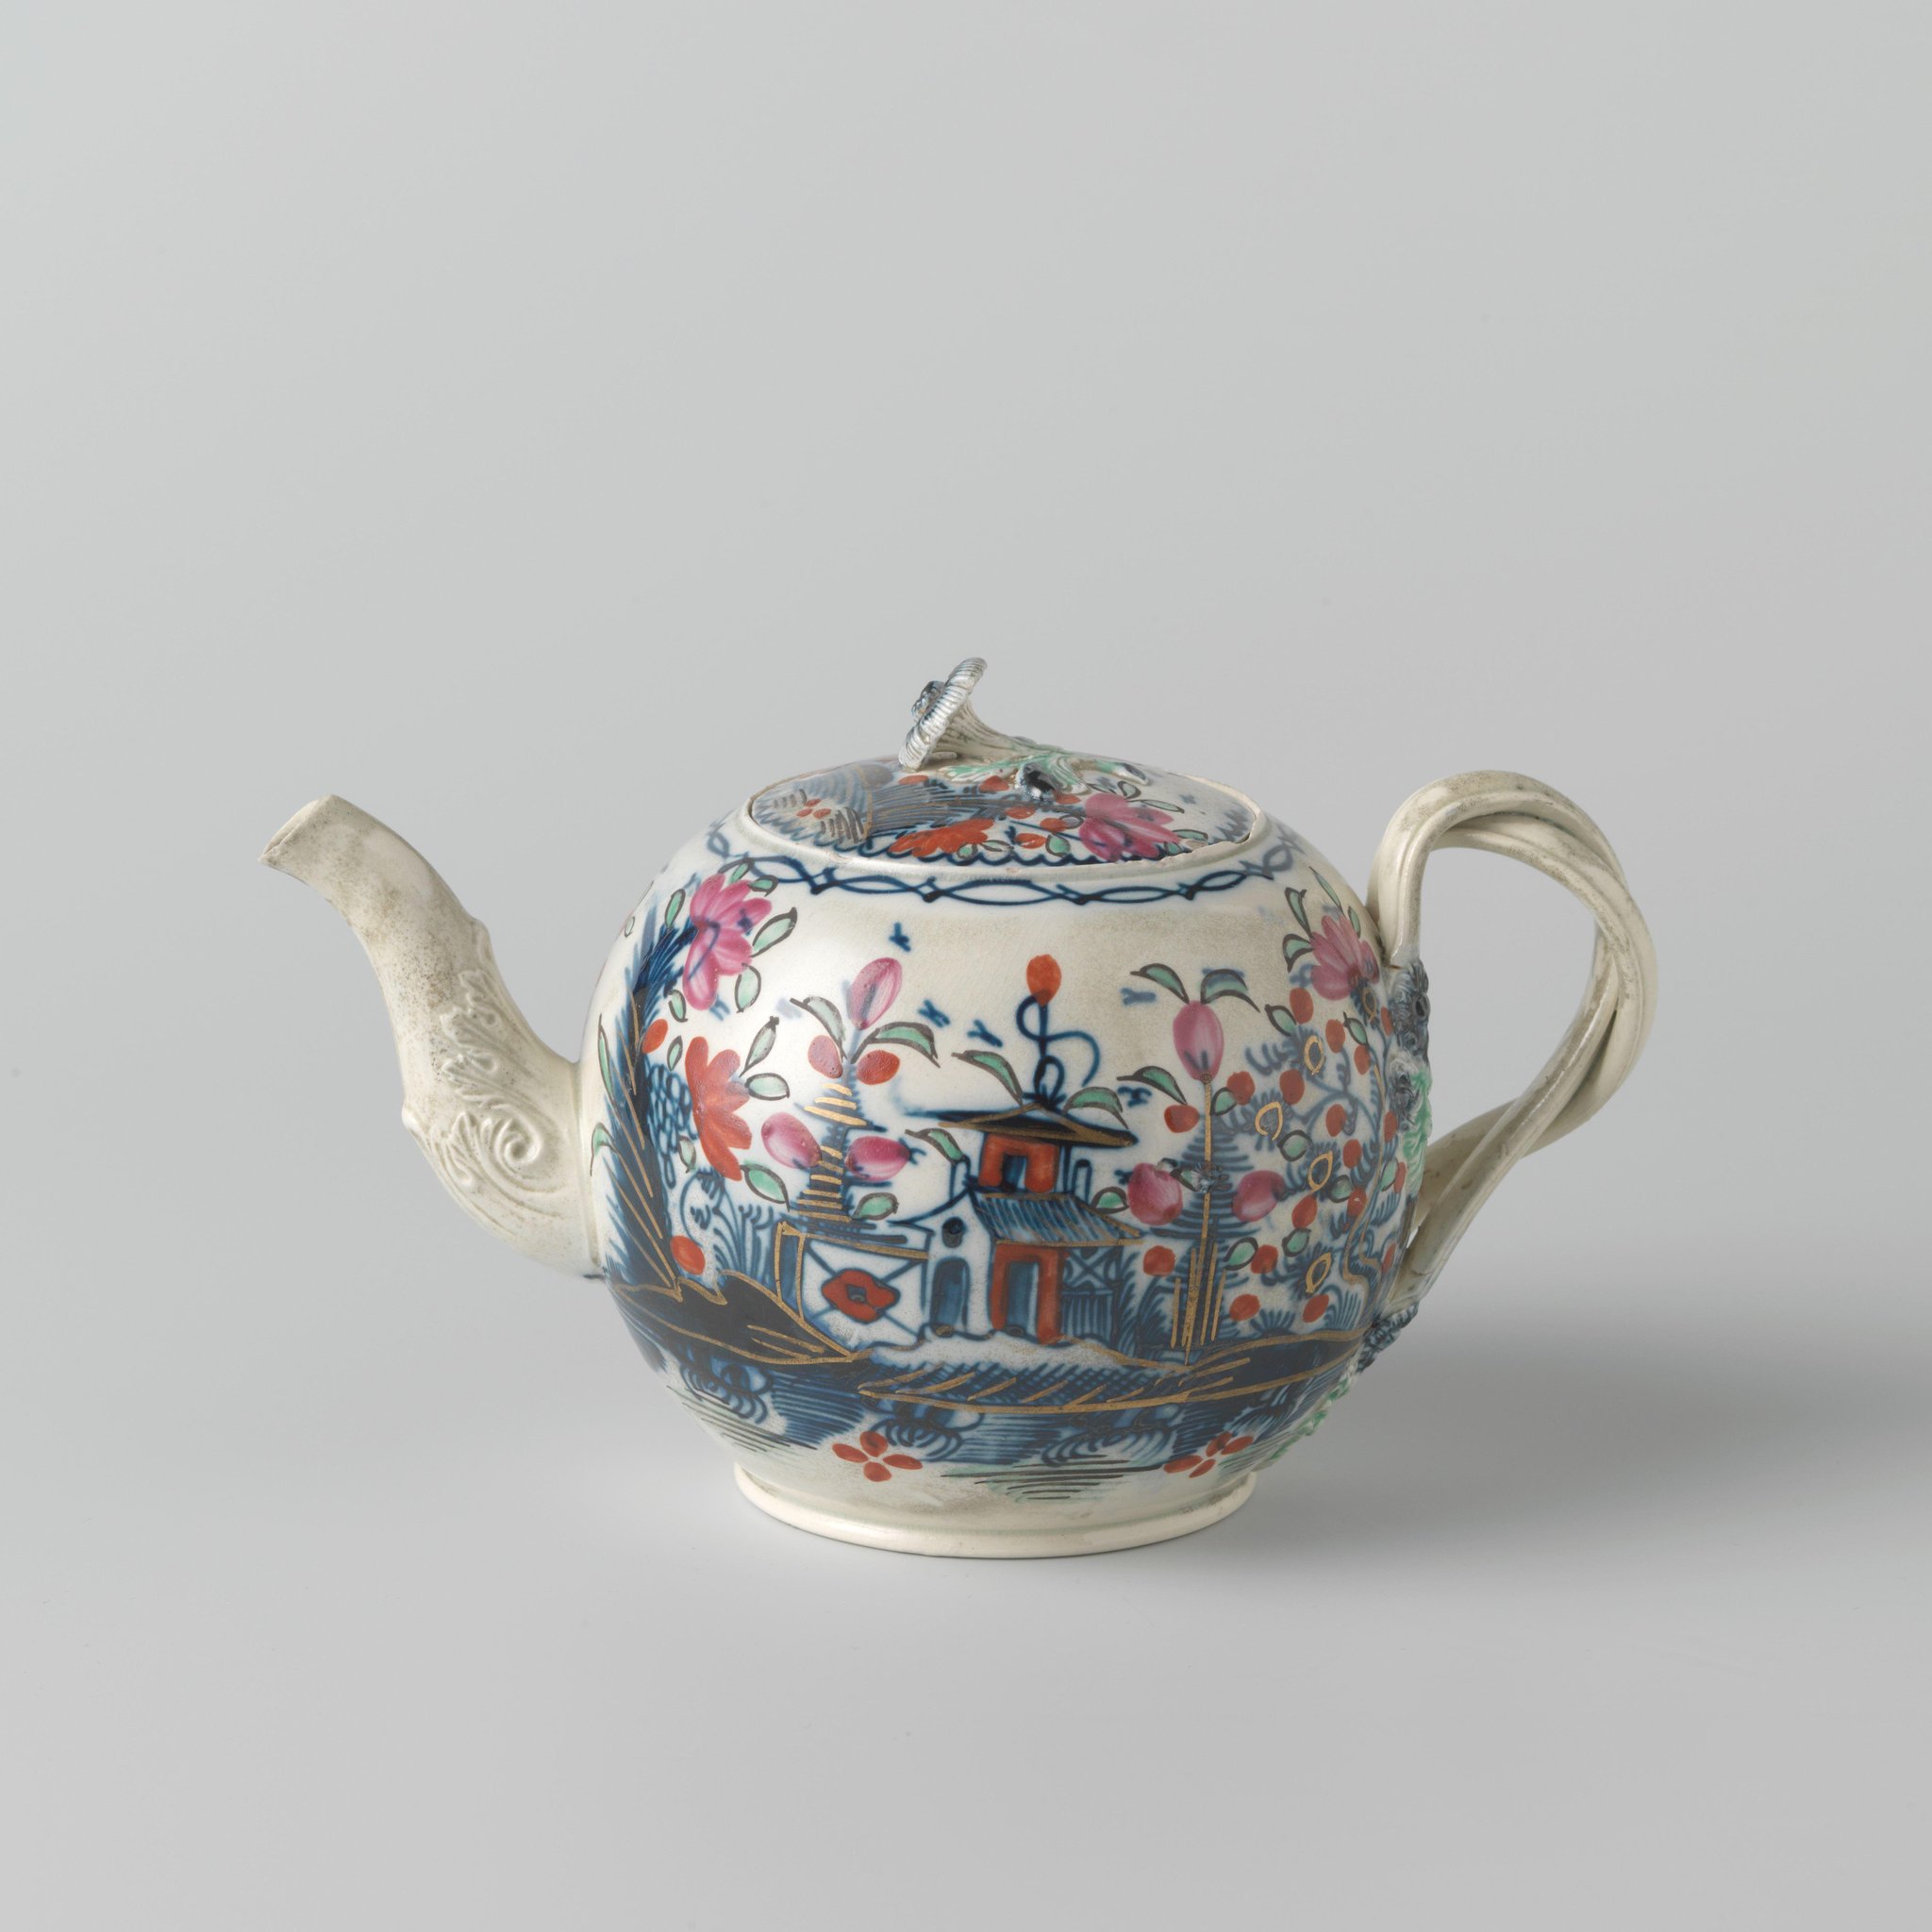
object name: pot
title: Theepot van hardgebakken aardewerk; Leeds creamware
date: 1770-1790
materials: earthenware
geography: leeds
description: Bolvormige theepot van hardgebakken aardewerk, met een blauwe decoratie onder de glazuur en een veelkleurige decoratie op de glazuur. De decoratie doet Japans aan en bestaat uit een landschap waarin gestileerde bomen, planten en huizen. De pot heeft een S-vormige tuit en een gevlochten C-vormig oor.